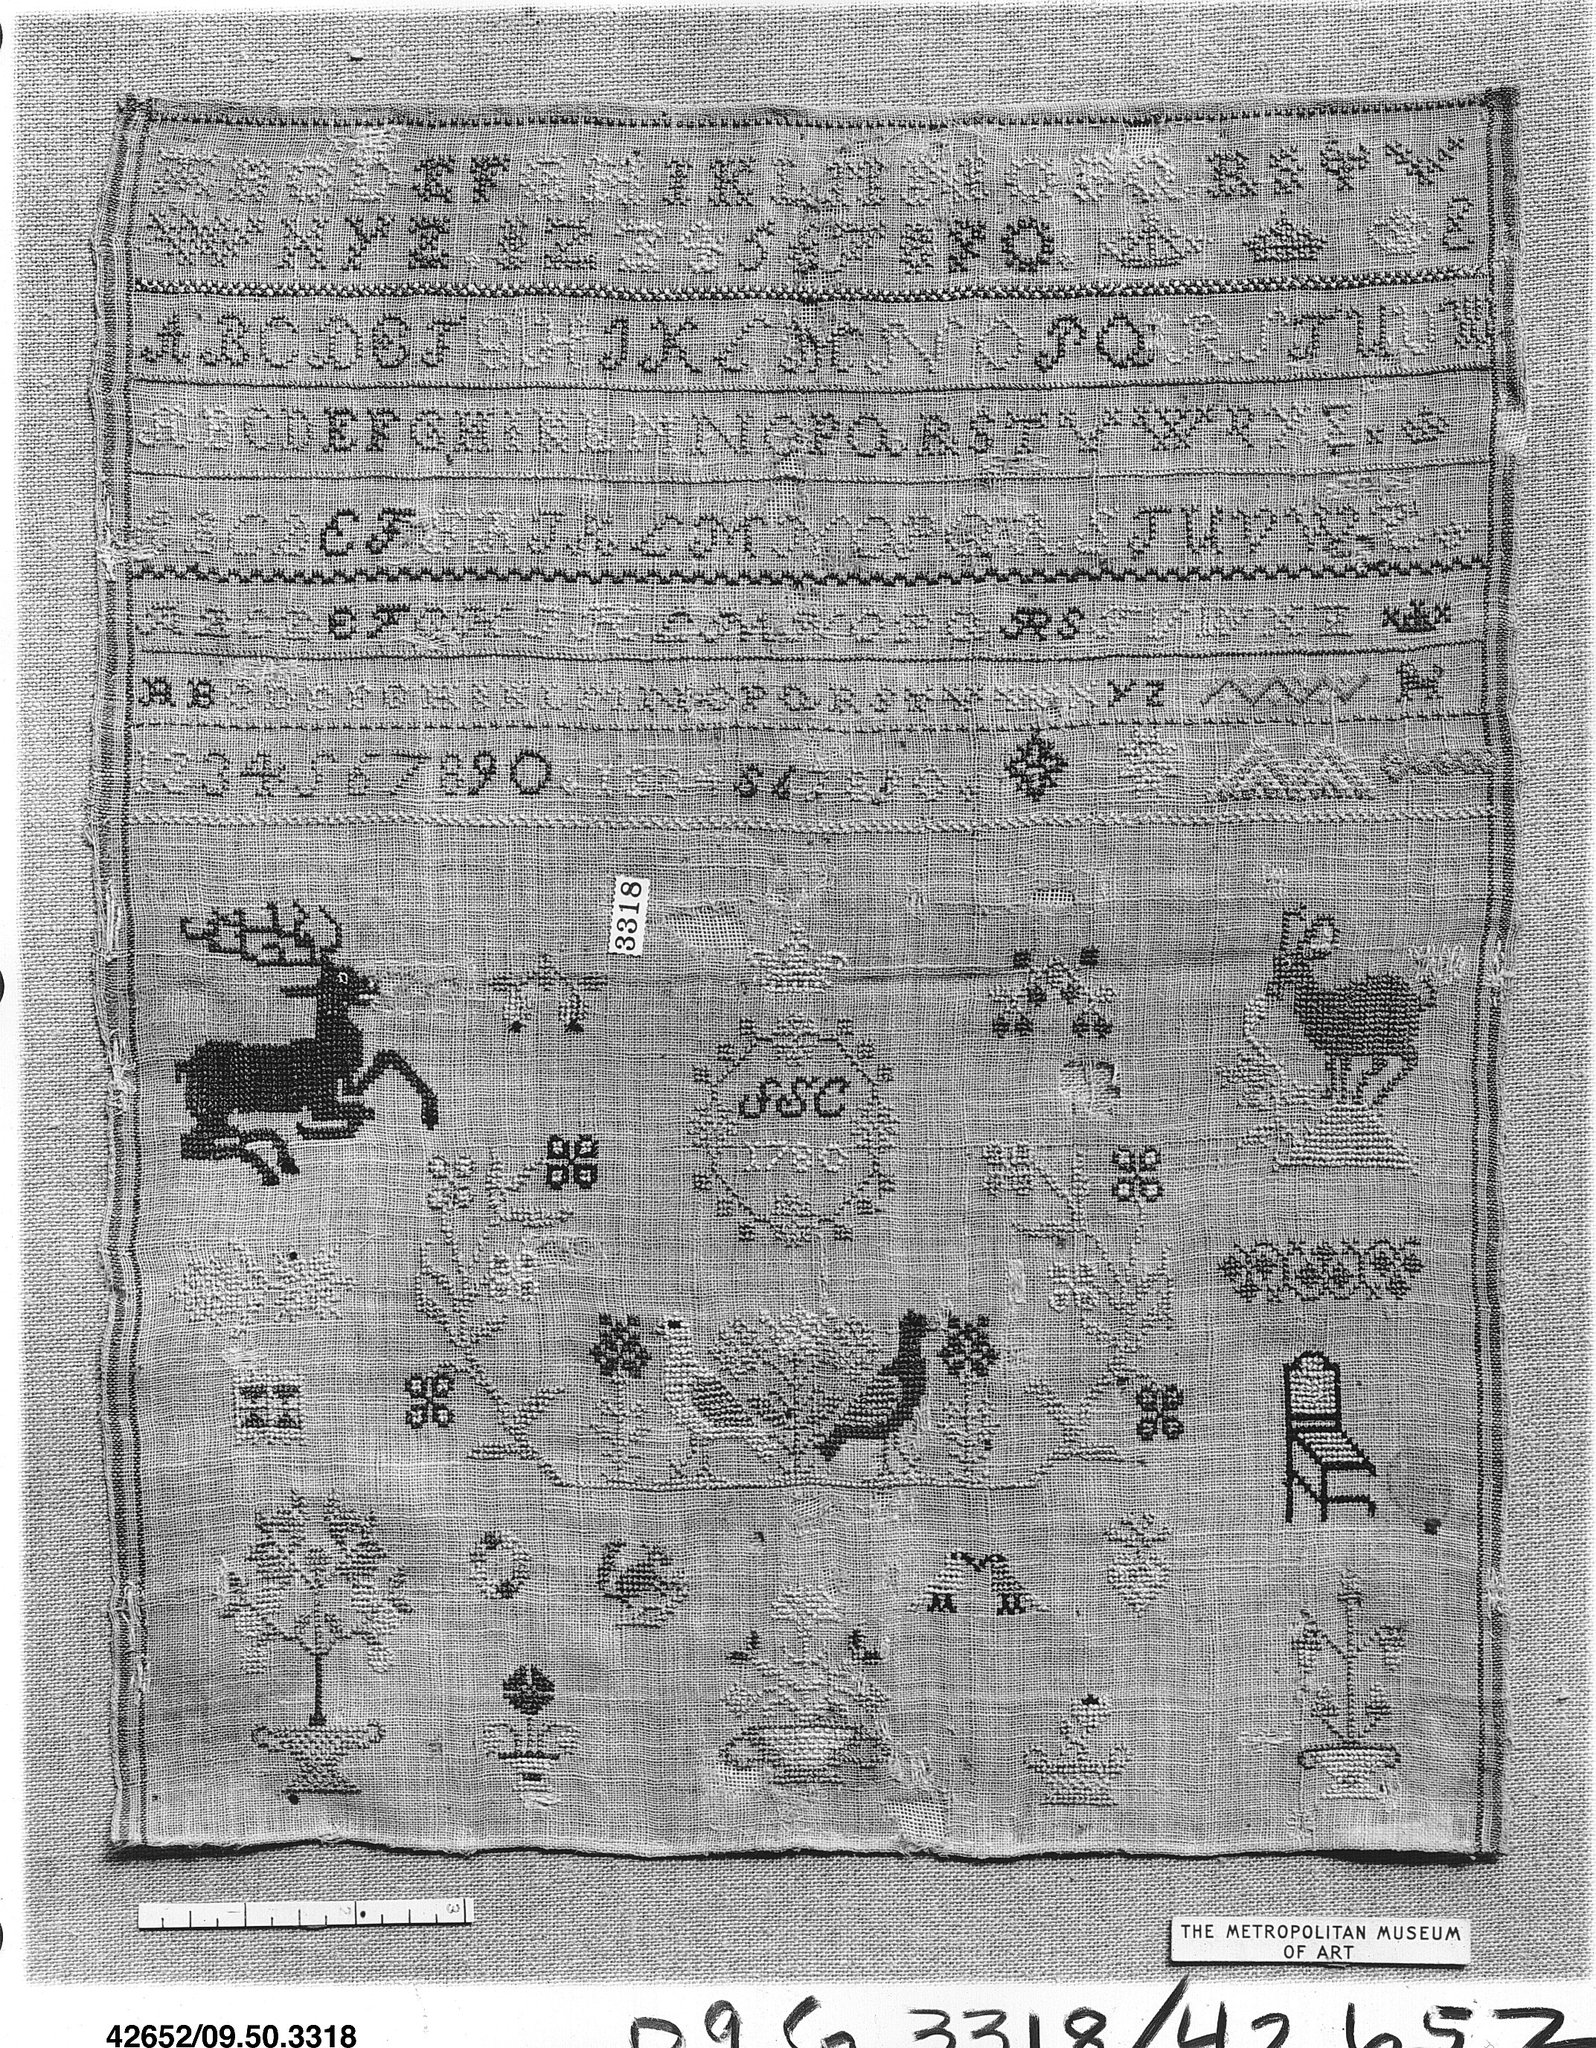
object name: sampler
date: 1780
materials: canvas, linen, silk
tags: birds,deer,flowers